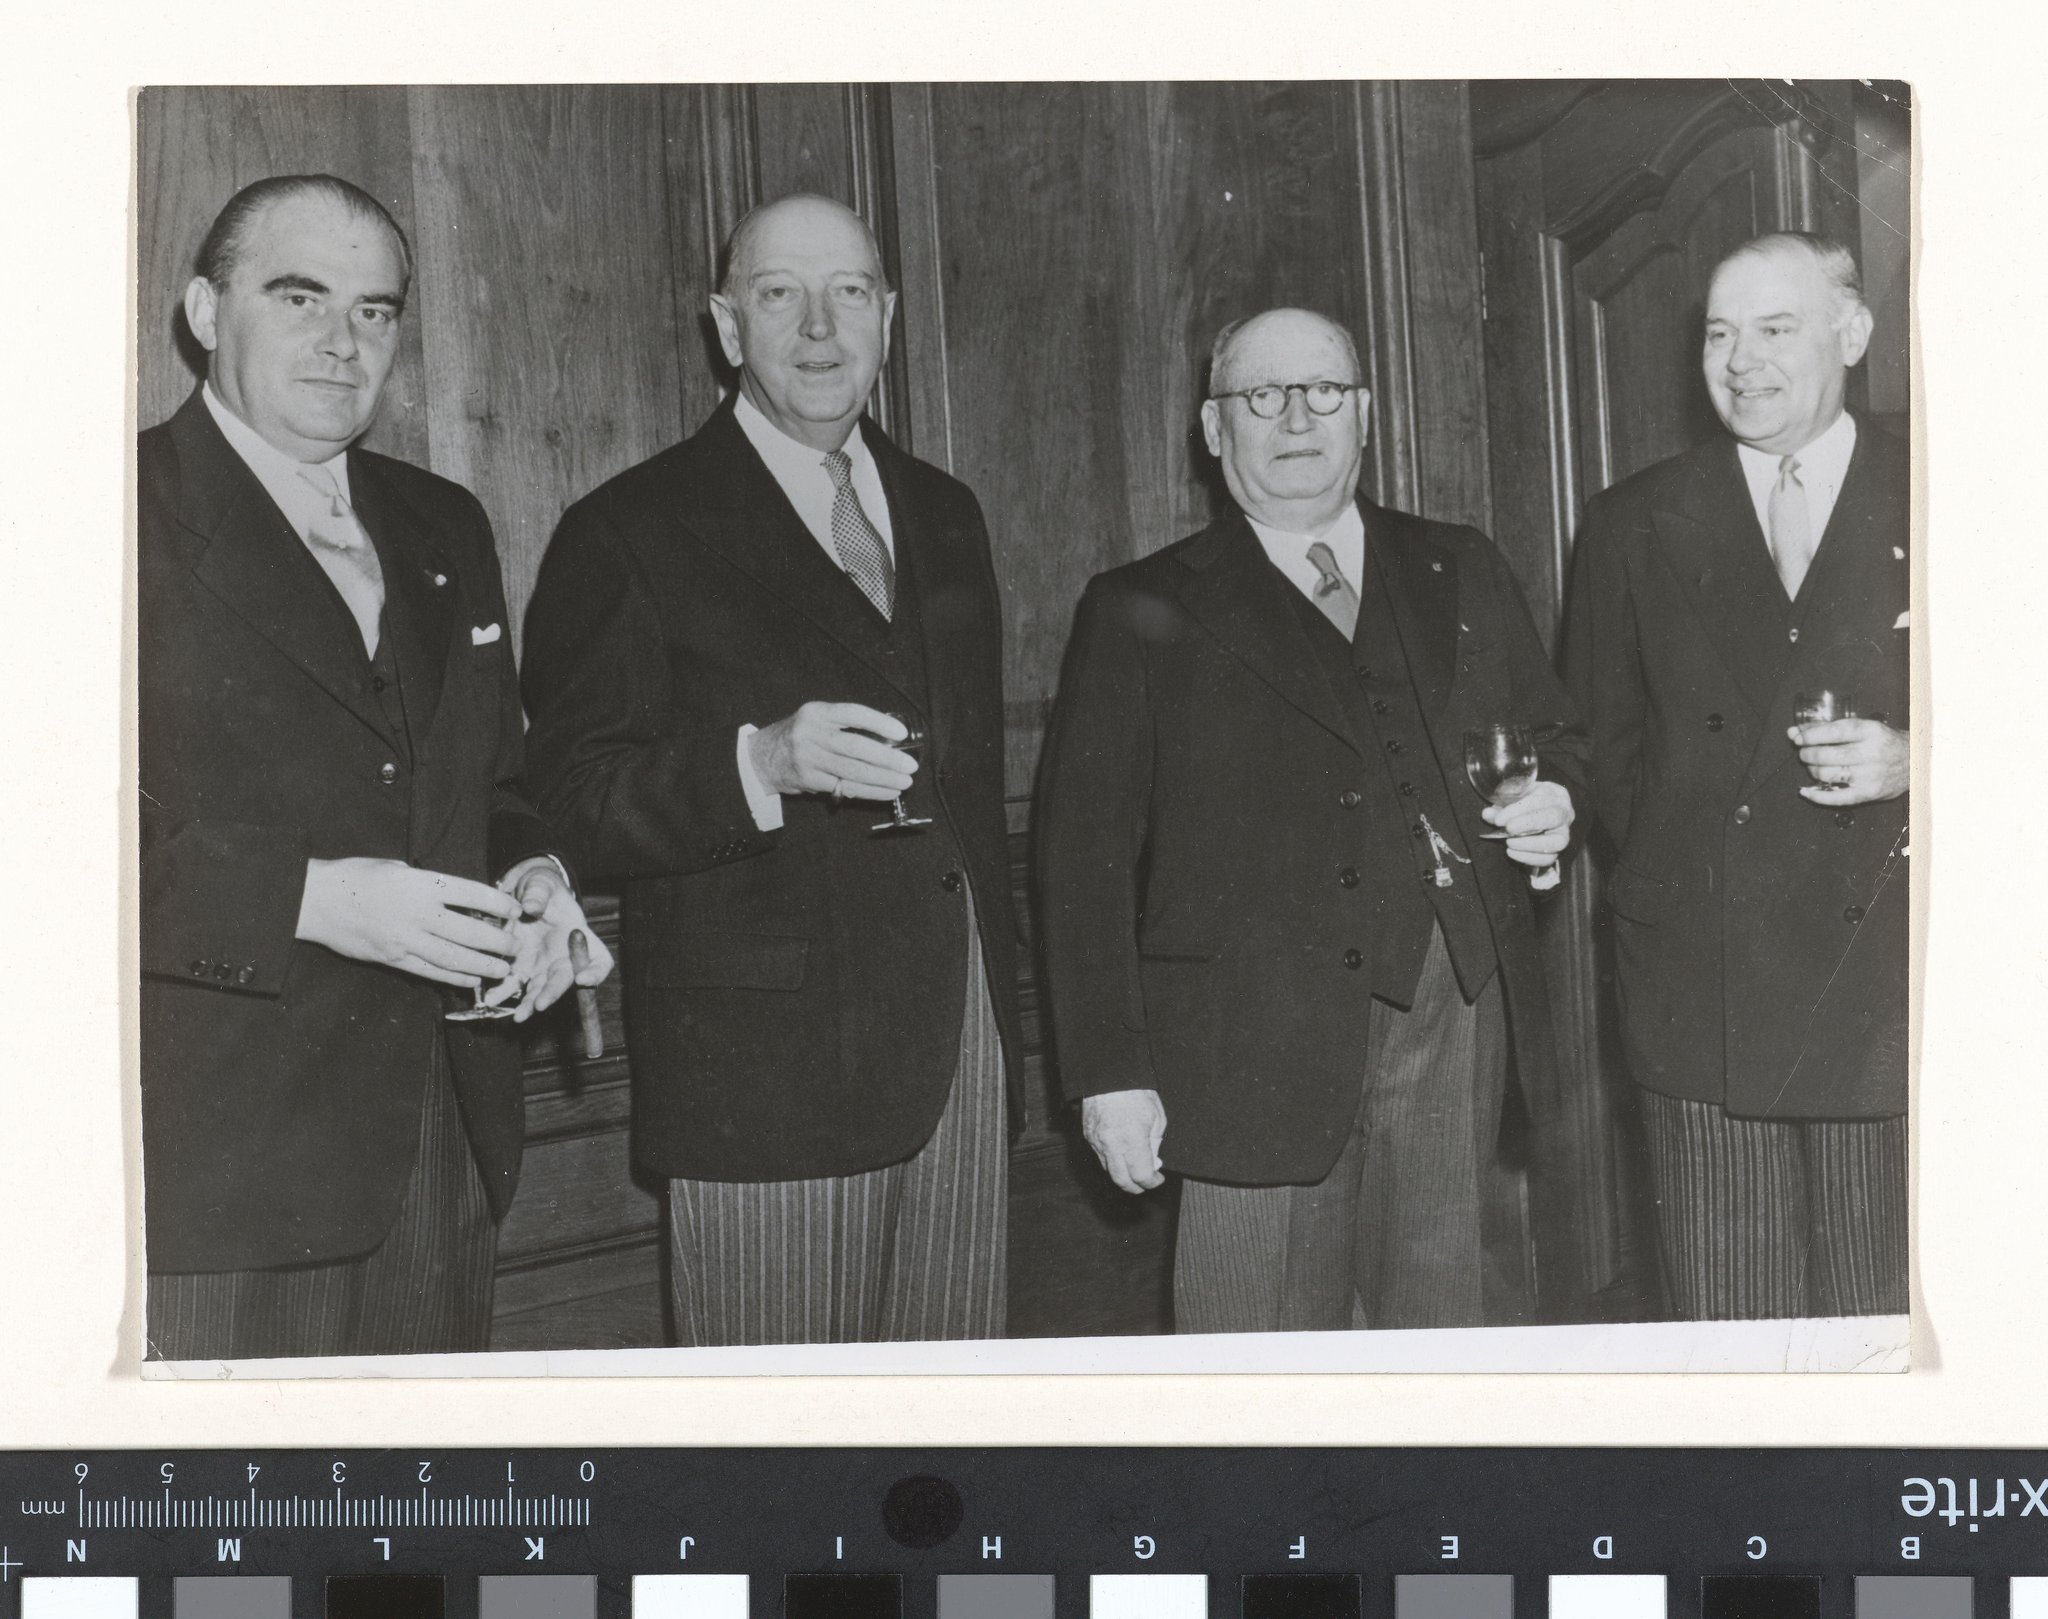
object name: photograph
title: Groepsportret van politici ter gelegenheid van de verjaardag Unie van Z-Afrika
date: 1949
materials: photographic support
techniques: gelatin silver print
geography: new york city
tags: daniël f. malan, zuid-afrika